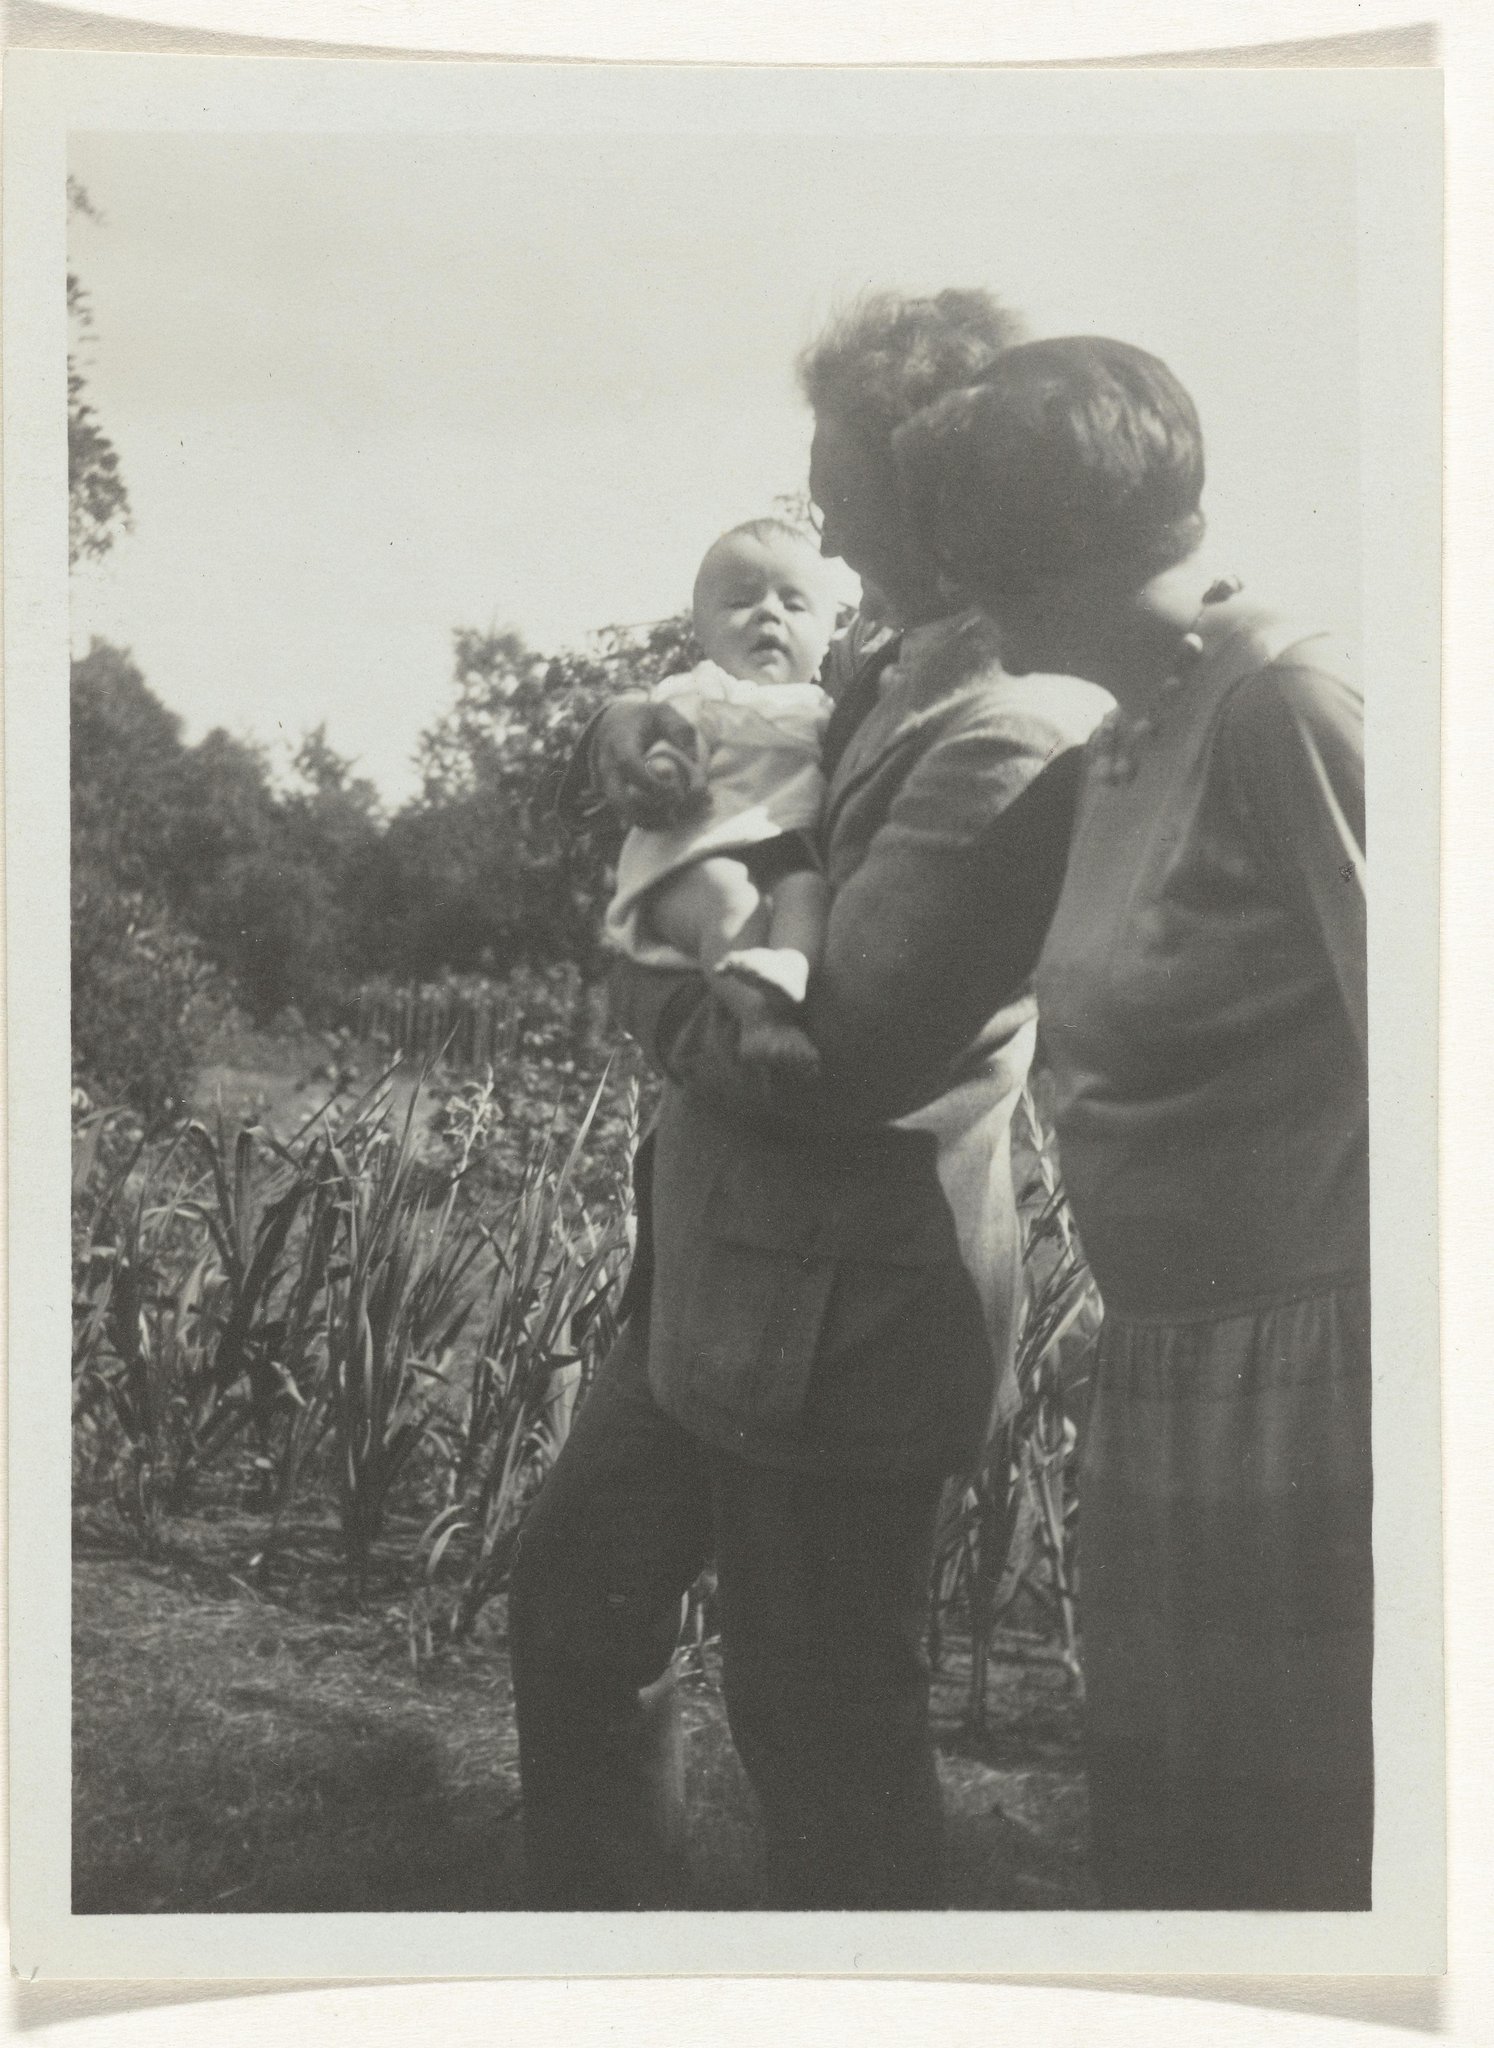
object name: photograph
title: Karl With met een kind op zijn arm in een tuin, vergezeld door een onbekende vrouw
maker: Anonymous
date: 1920-1935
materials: paper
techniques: gelatin silver print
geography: germany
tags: karl with, father and child(ren), man and child(ren) (family group), germany